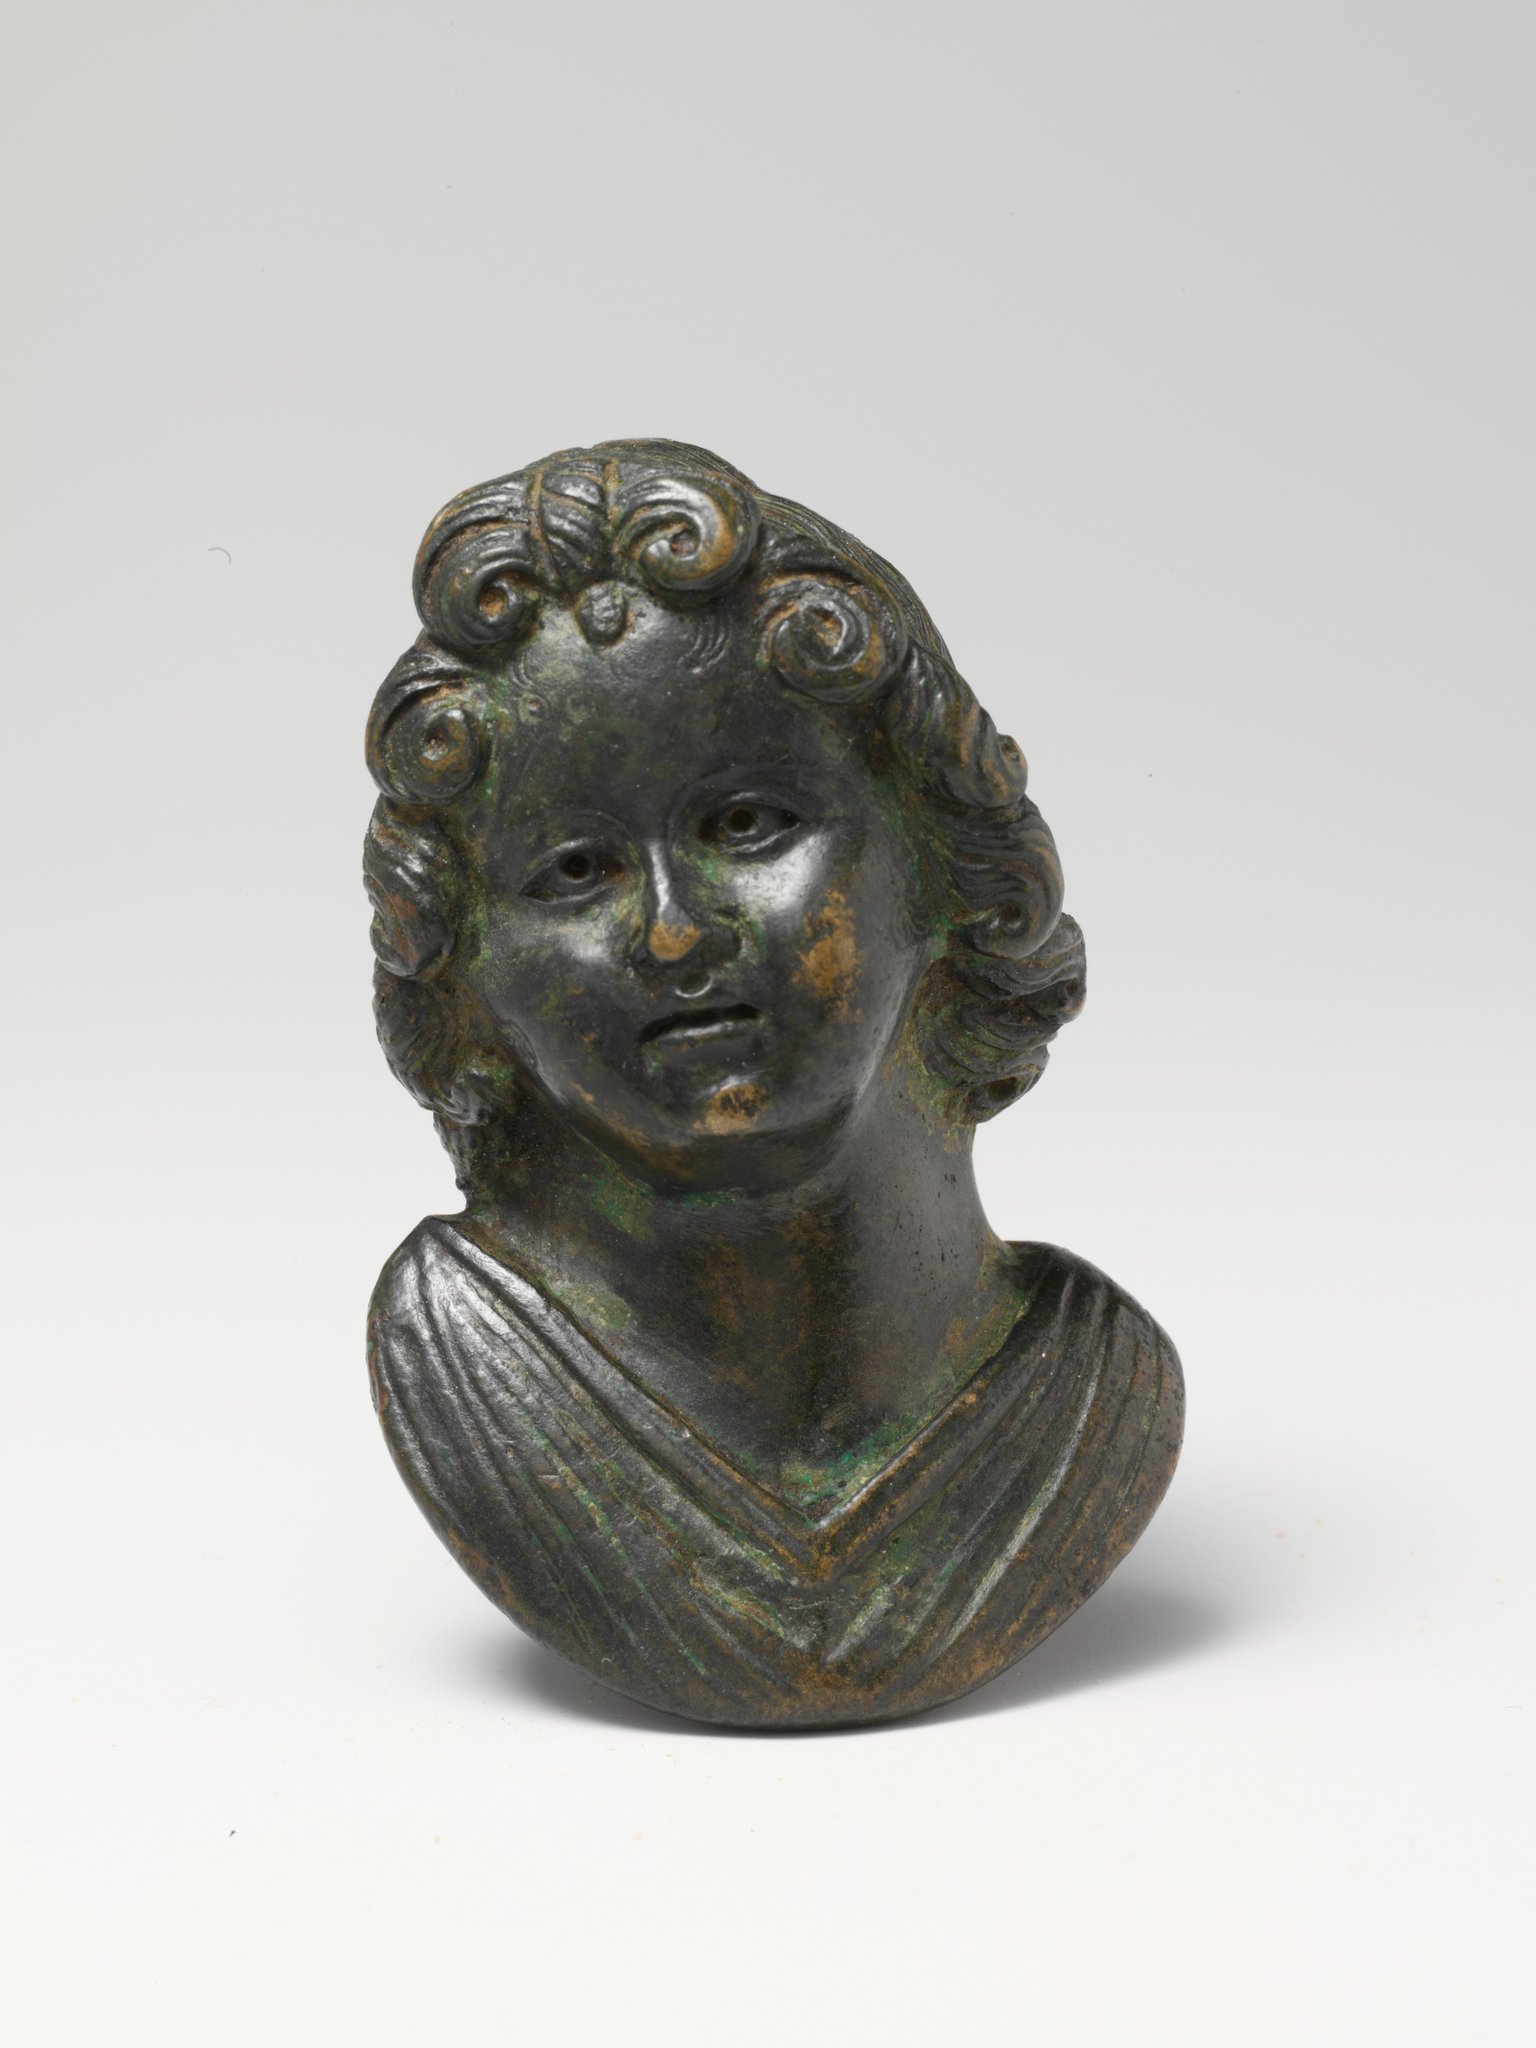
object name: portrait bust of a boy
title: Bronze portrait bust of a boy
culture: greek or roman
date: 134 BCE-200 CE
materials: bronze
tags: boys,portraits